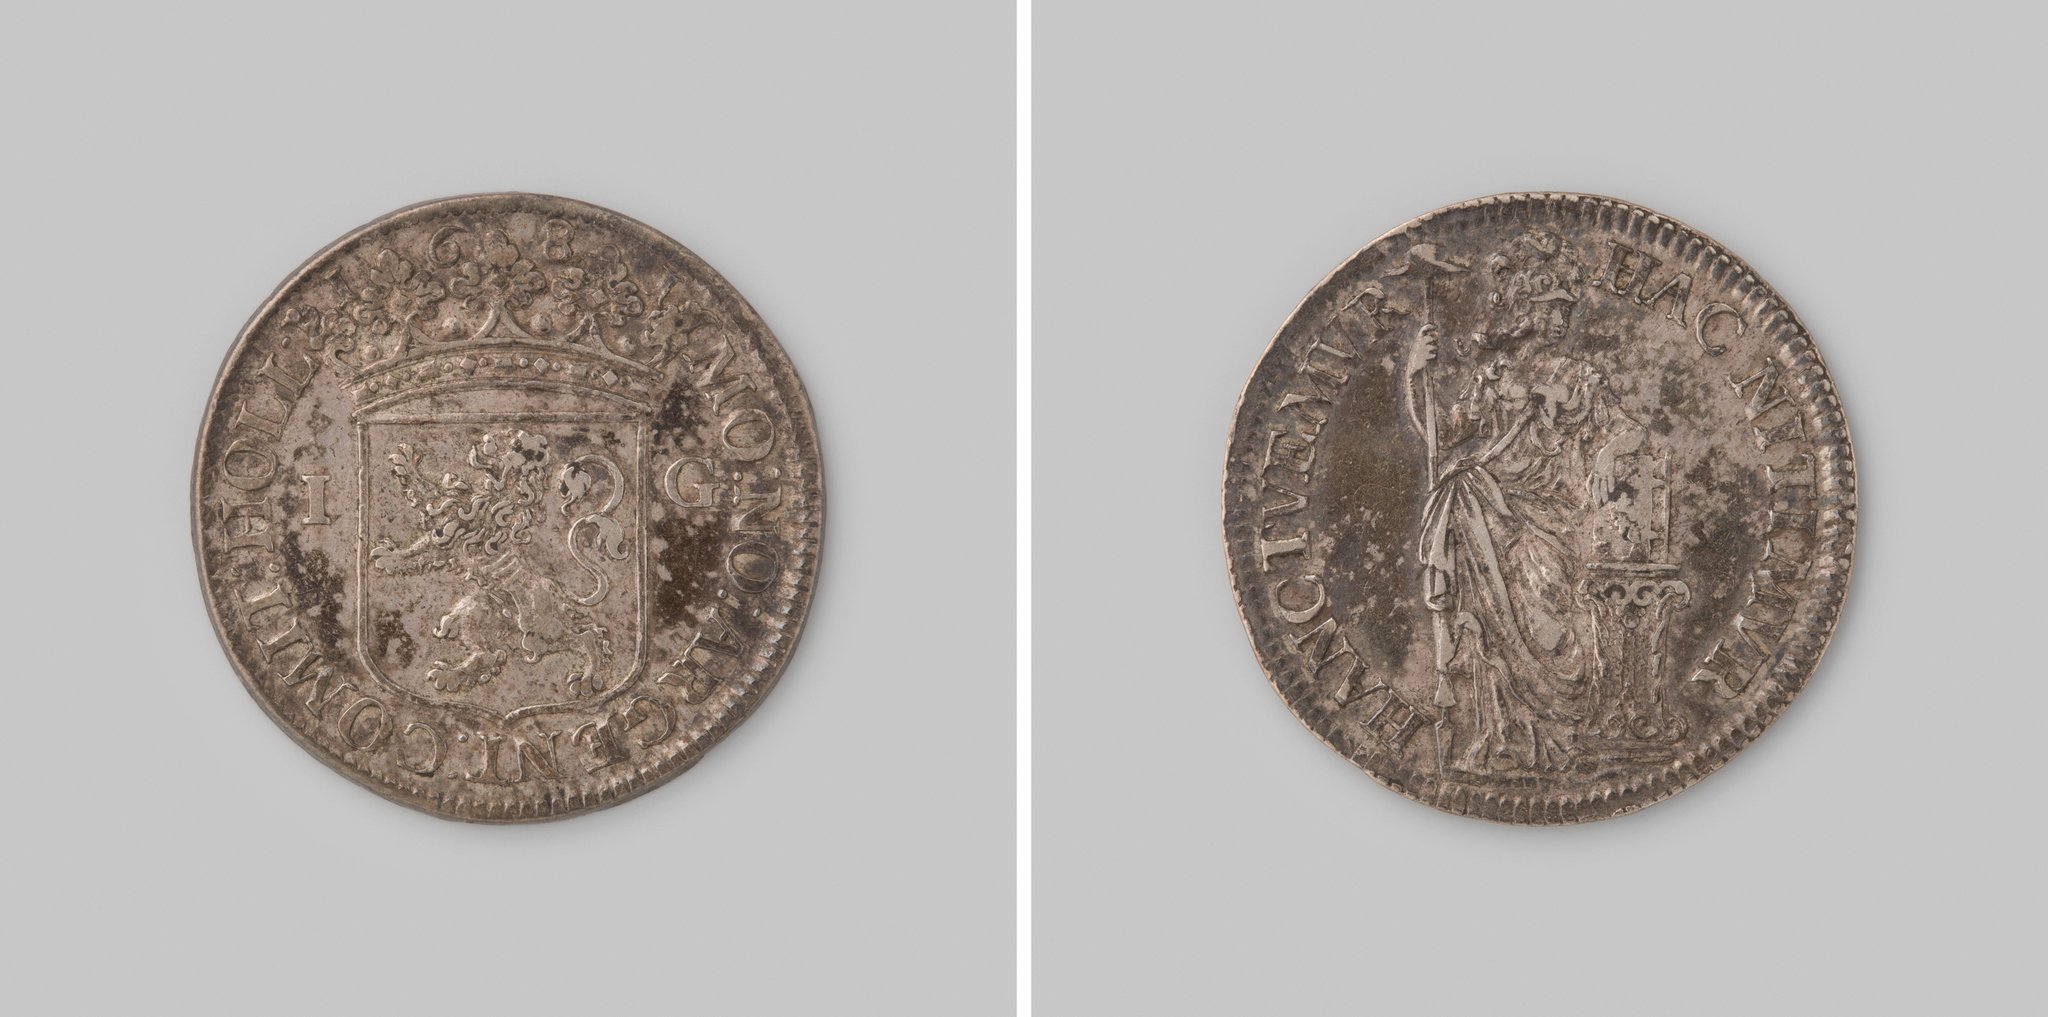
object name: coin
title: Holland, provinciale gulden, 1681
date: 1681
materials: silver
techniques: striking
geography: dordrecht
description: Zilveren munt. Voorzijde: gekroond wapenschild van Holland. Boven kroon jaartal. Keerzijde: staande Nederlandse maagd met in rechterhand speer, waarop hoed en met linkerhand steunend op altaar, waarop bijlbel.